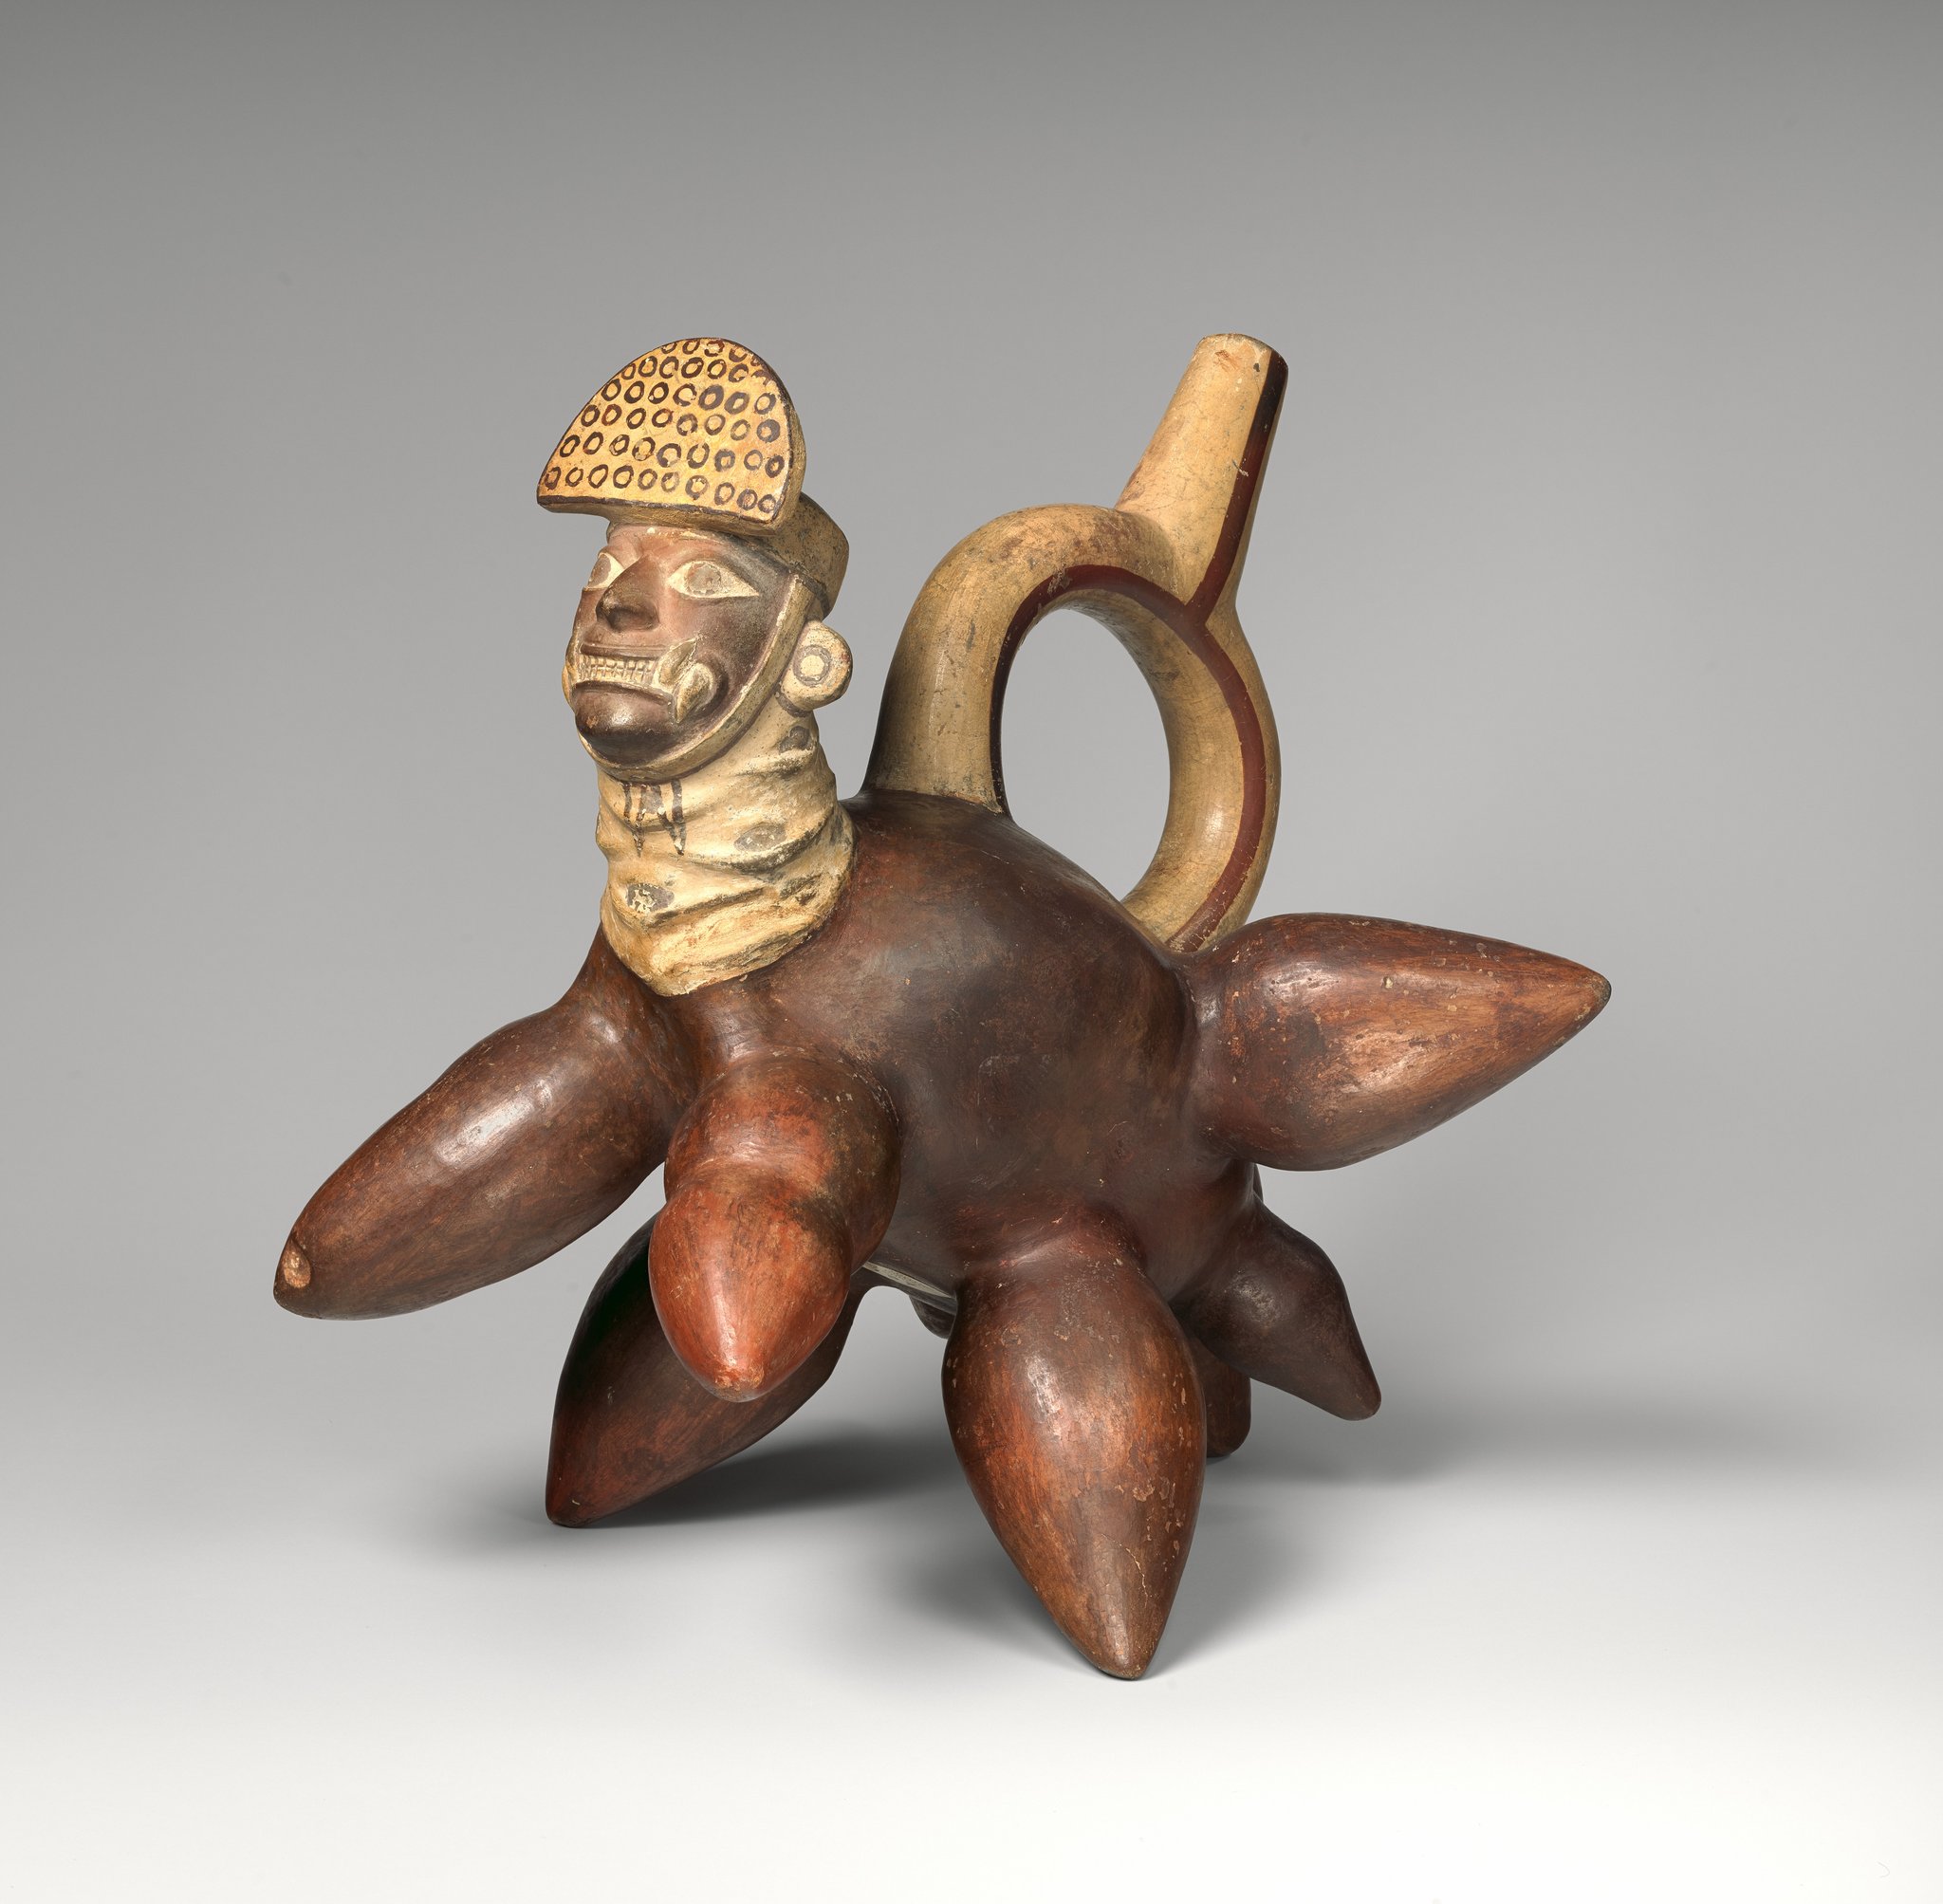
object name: bottle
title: Tuber-inspired stirrup-spout bottle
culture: moche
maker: moche artist(s)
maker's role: artist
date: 600-800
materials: ceramic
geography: peru